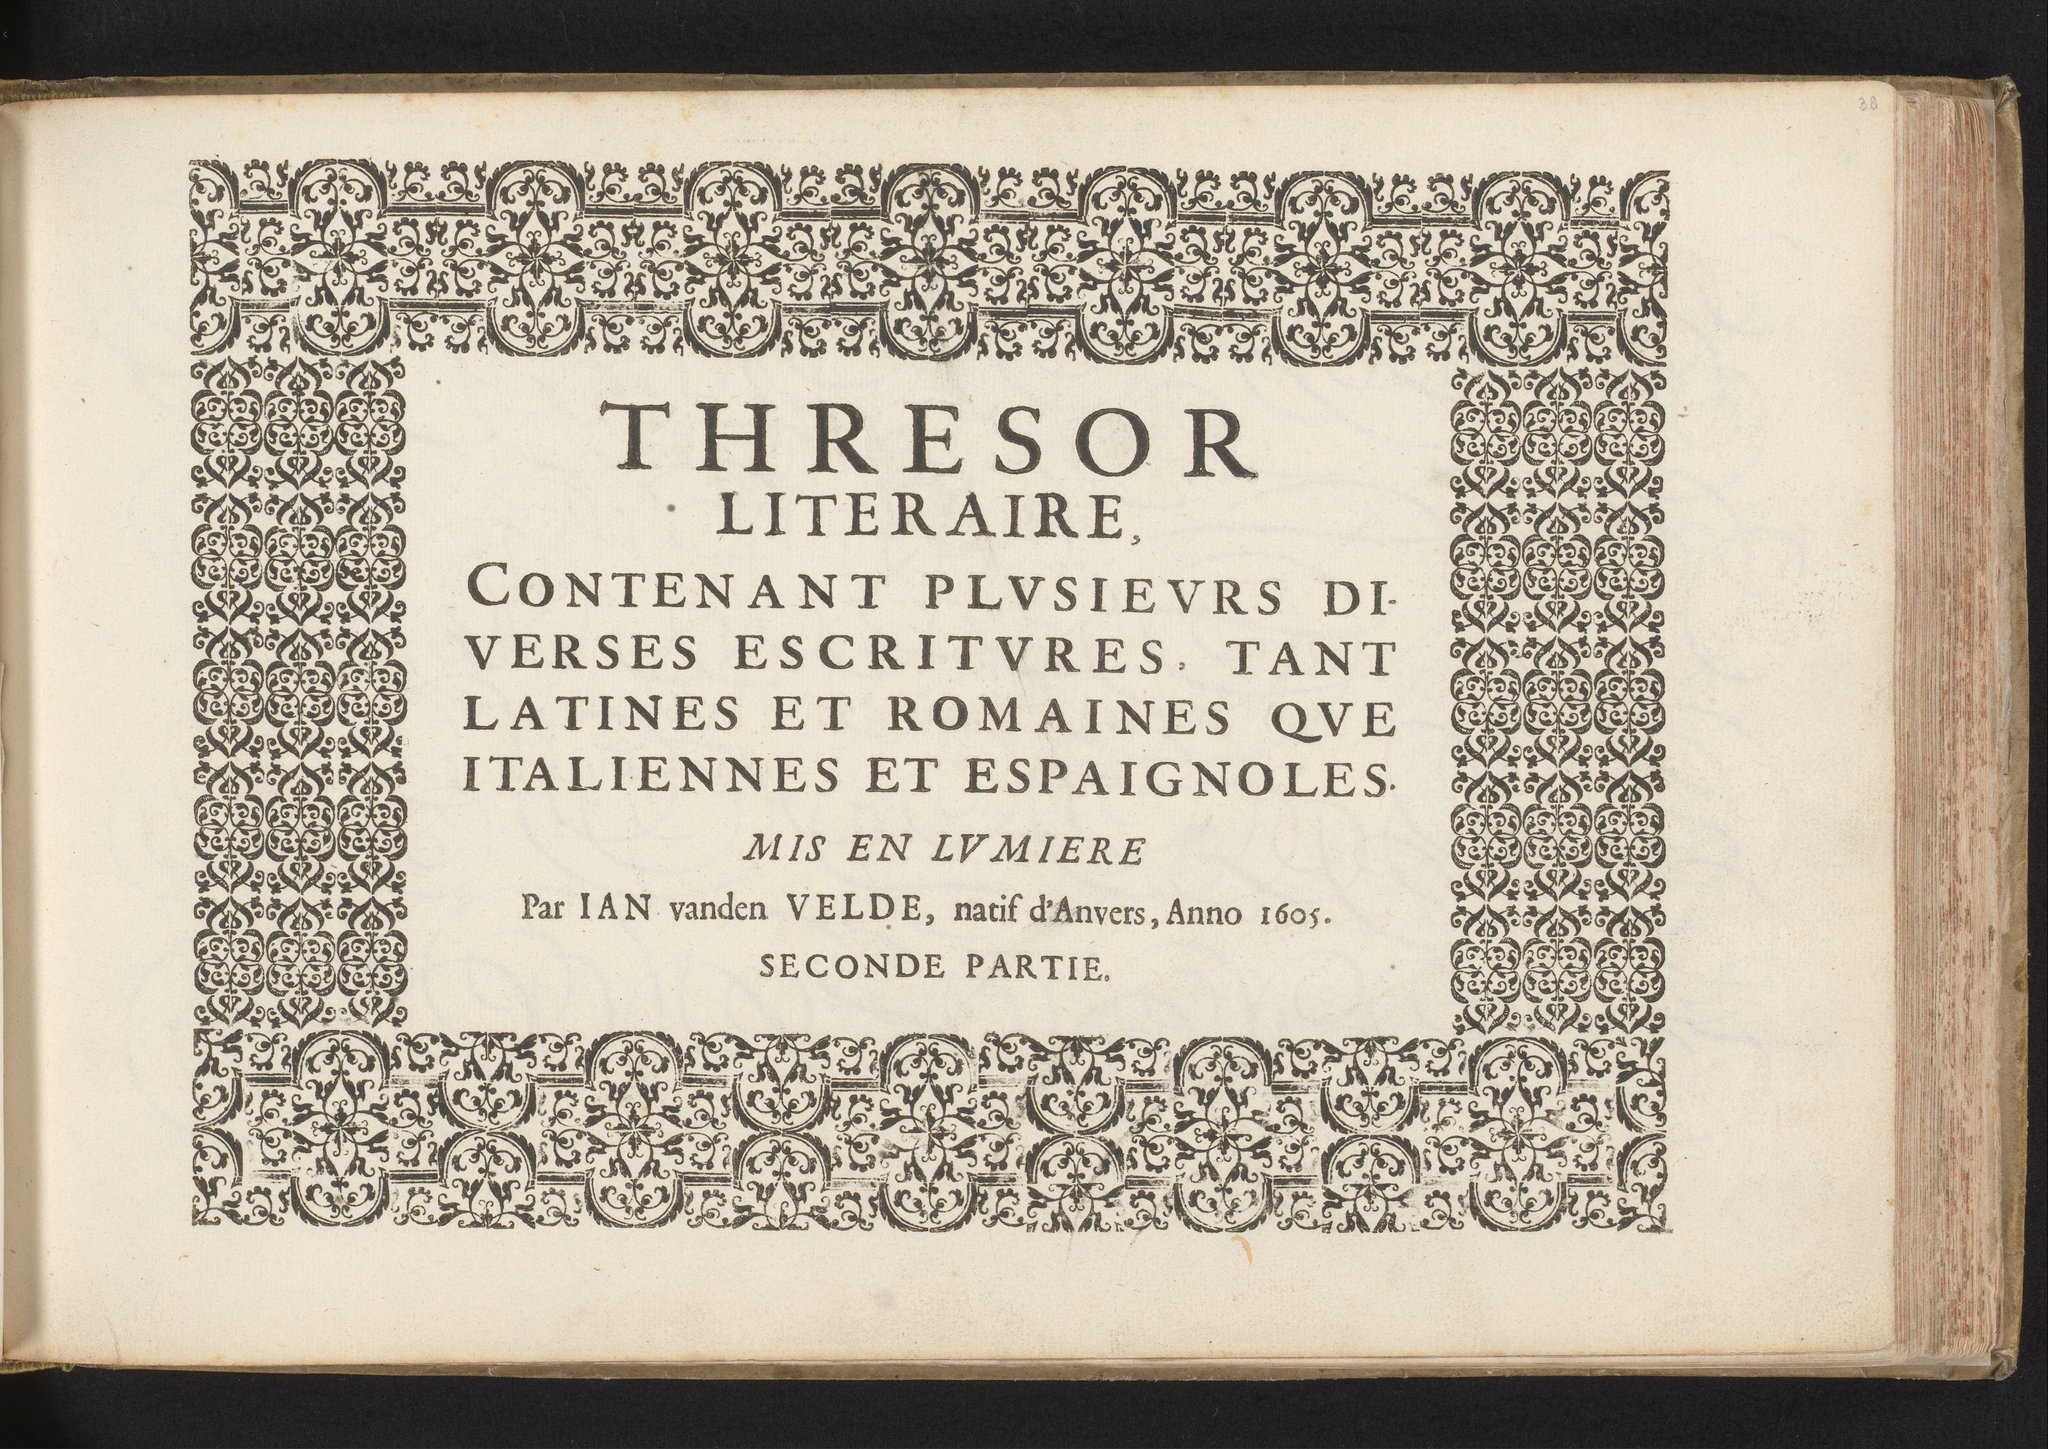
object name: text sheet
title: Thresor literaire, contenant plusieurs diverses escritures, tant Latines et Romaines que Italiennes et Espaignoles (...) Seconde Partie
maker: jan van de velde (i)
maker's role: painter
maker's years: 1568-1623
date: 1605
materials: paper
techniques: letterpress printing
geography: rotterdam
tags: title-page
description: Tussentitel in een omlijsting van fleurons, tweede deel van het werk: Spieghel der schrijfkonste. Het tekstblad maakt deel uit van een album.